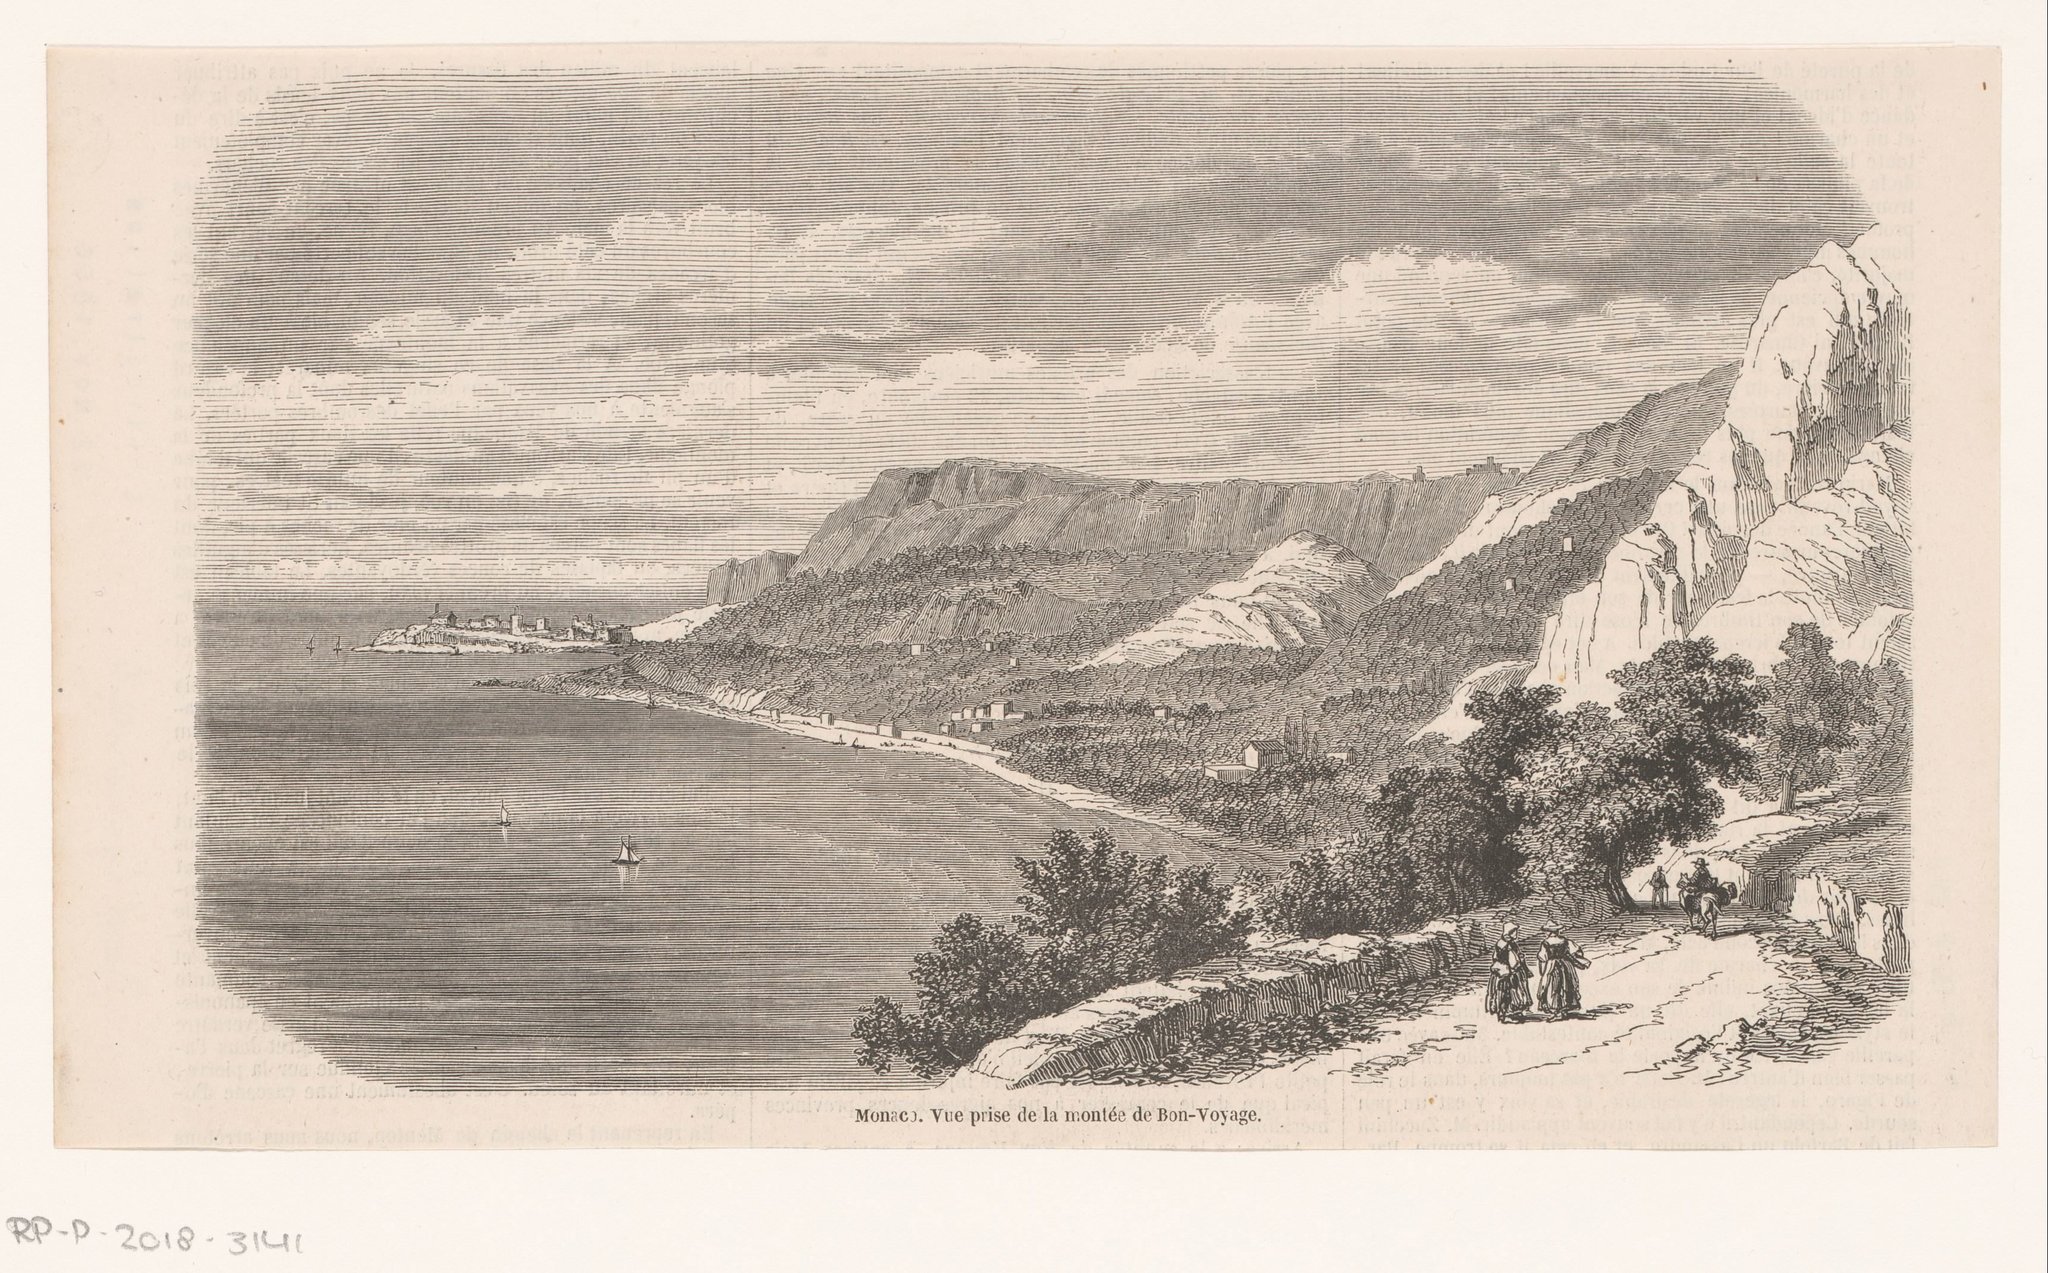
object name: book illustration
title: Monaco. Vue prise de la montée de Bon-Voyage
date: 1856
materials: paper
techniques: letterpress printing, engraving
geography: paris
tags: gulf, bay, prospect of city, town panorama, silhouette of city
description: Prent uit: L'Illustration 28 (1856), nr. 717: 22 november 1856, p. 332.